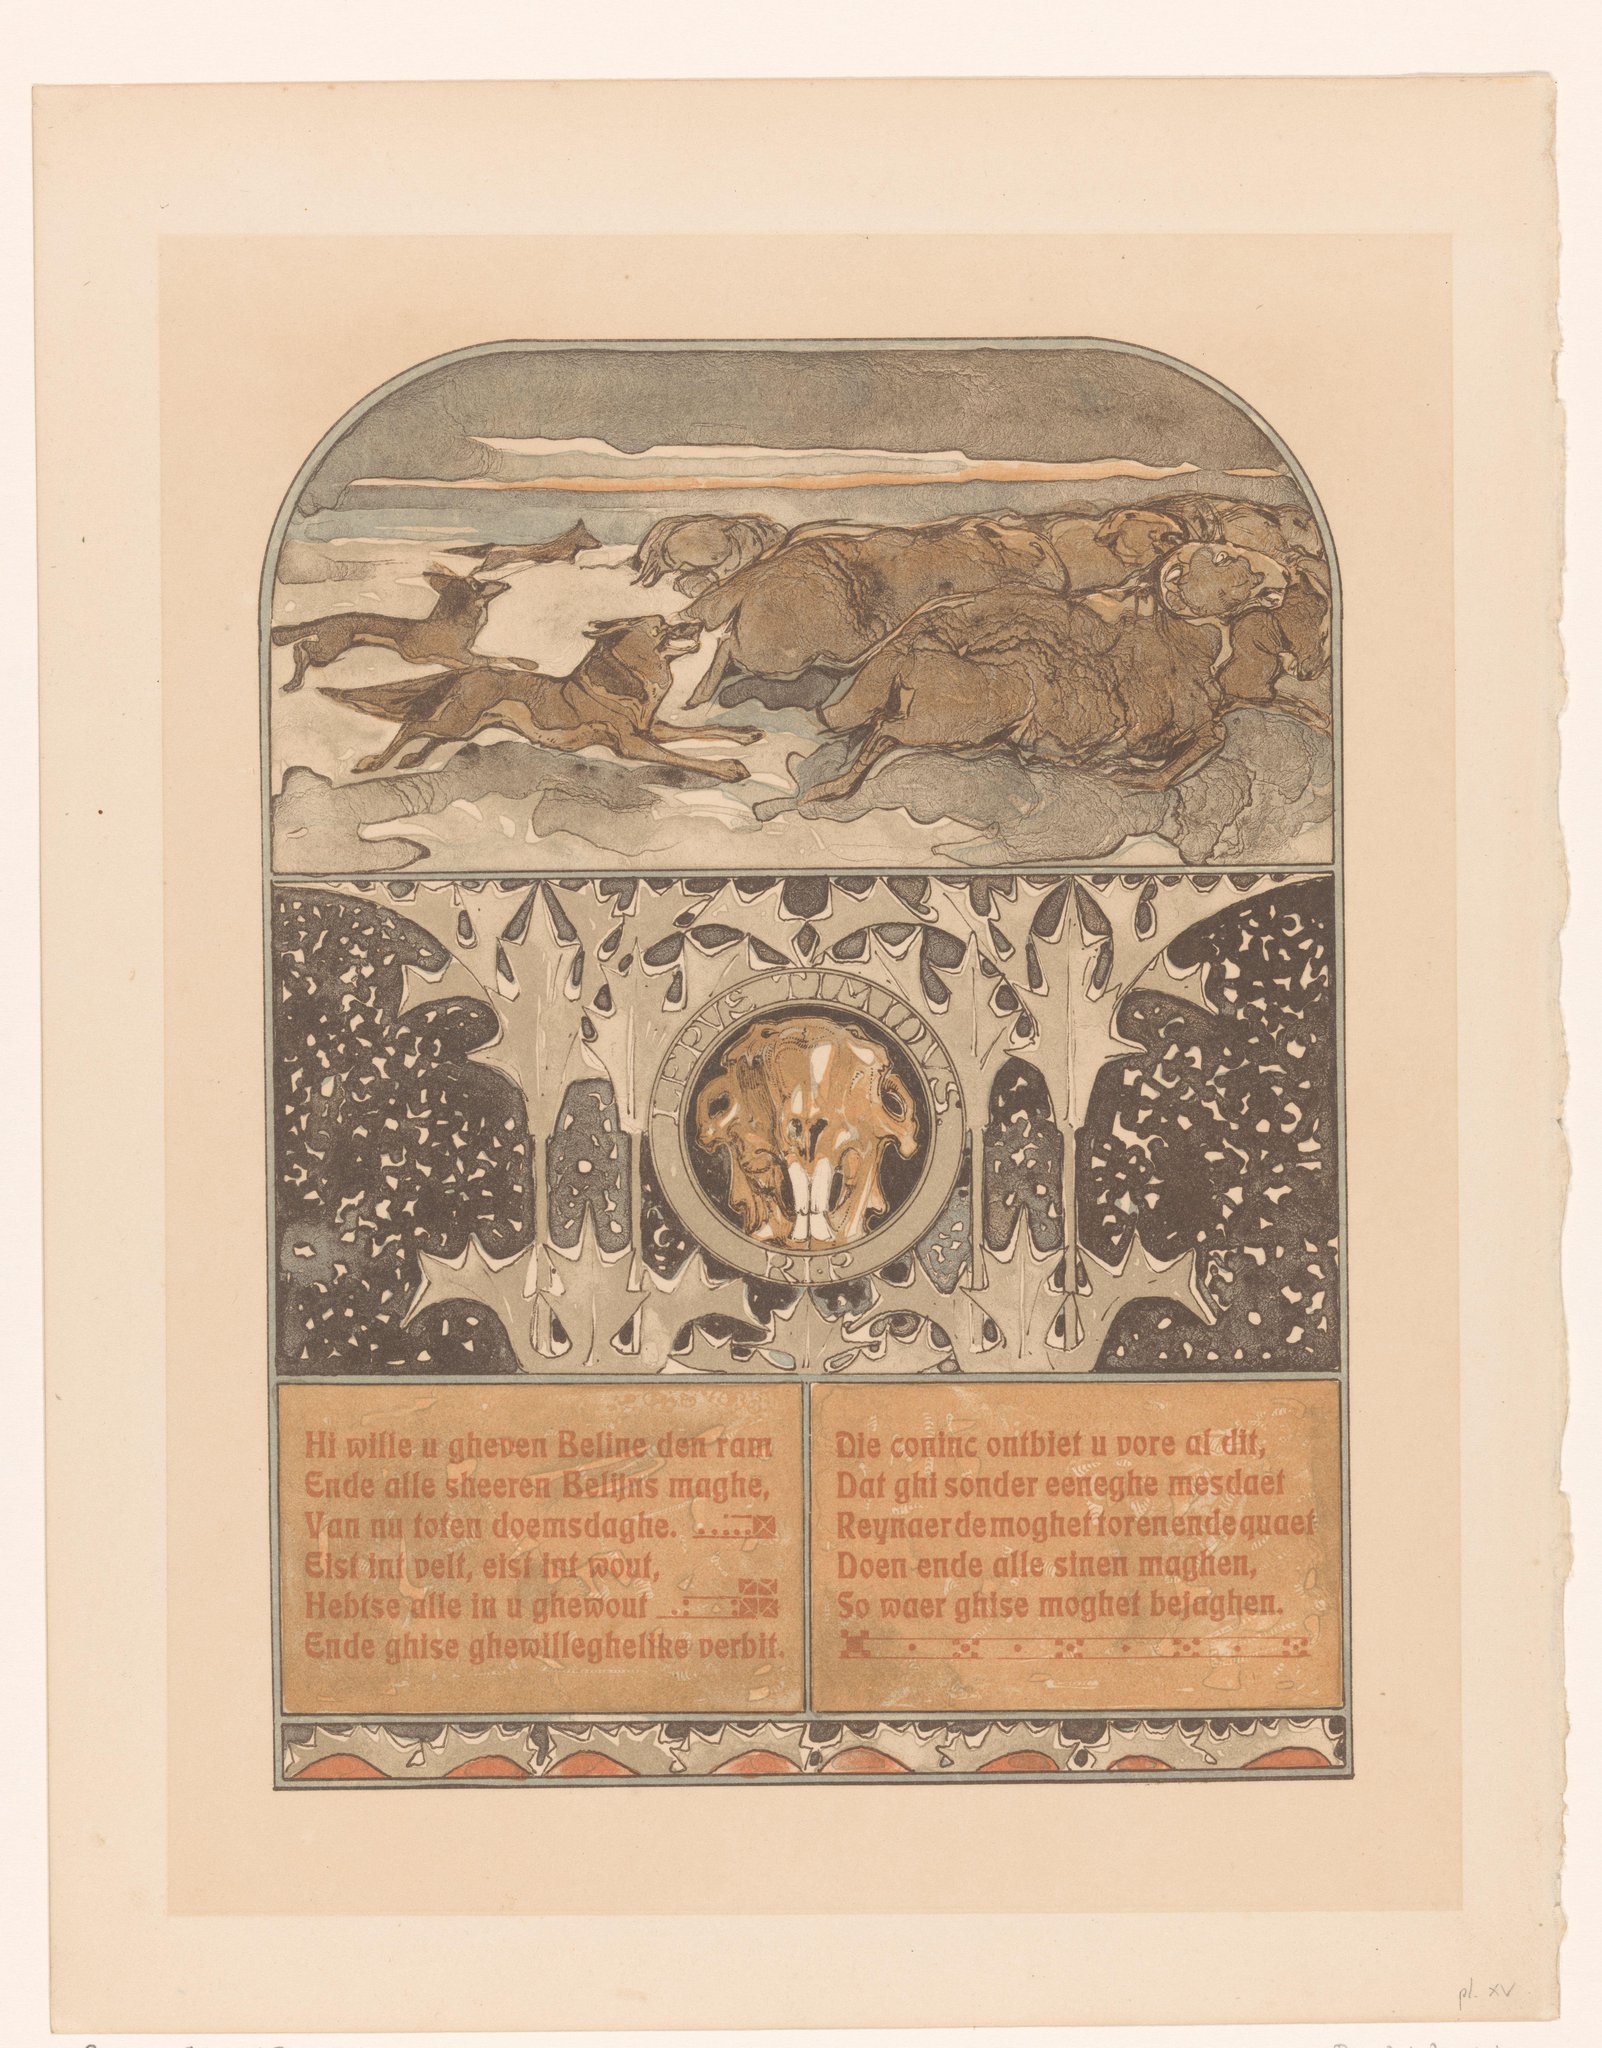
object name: print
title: Roedel wolven jagend op schapen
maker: bernard willem wierink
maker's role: draughtsman, print maker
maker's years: 1856-1939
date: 1910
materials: paper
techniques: lithograph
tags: fable of reynard the fox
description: Prent gebruikt in: Streuvels, Stijn (Frank Lateur). Reinaert de Vos naar verschillende uitgaven van het middeleeuwsche epos. Amsterdam: L.J. Veen, 1910.